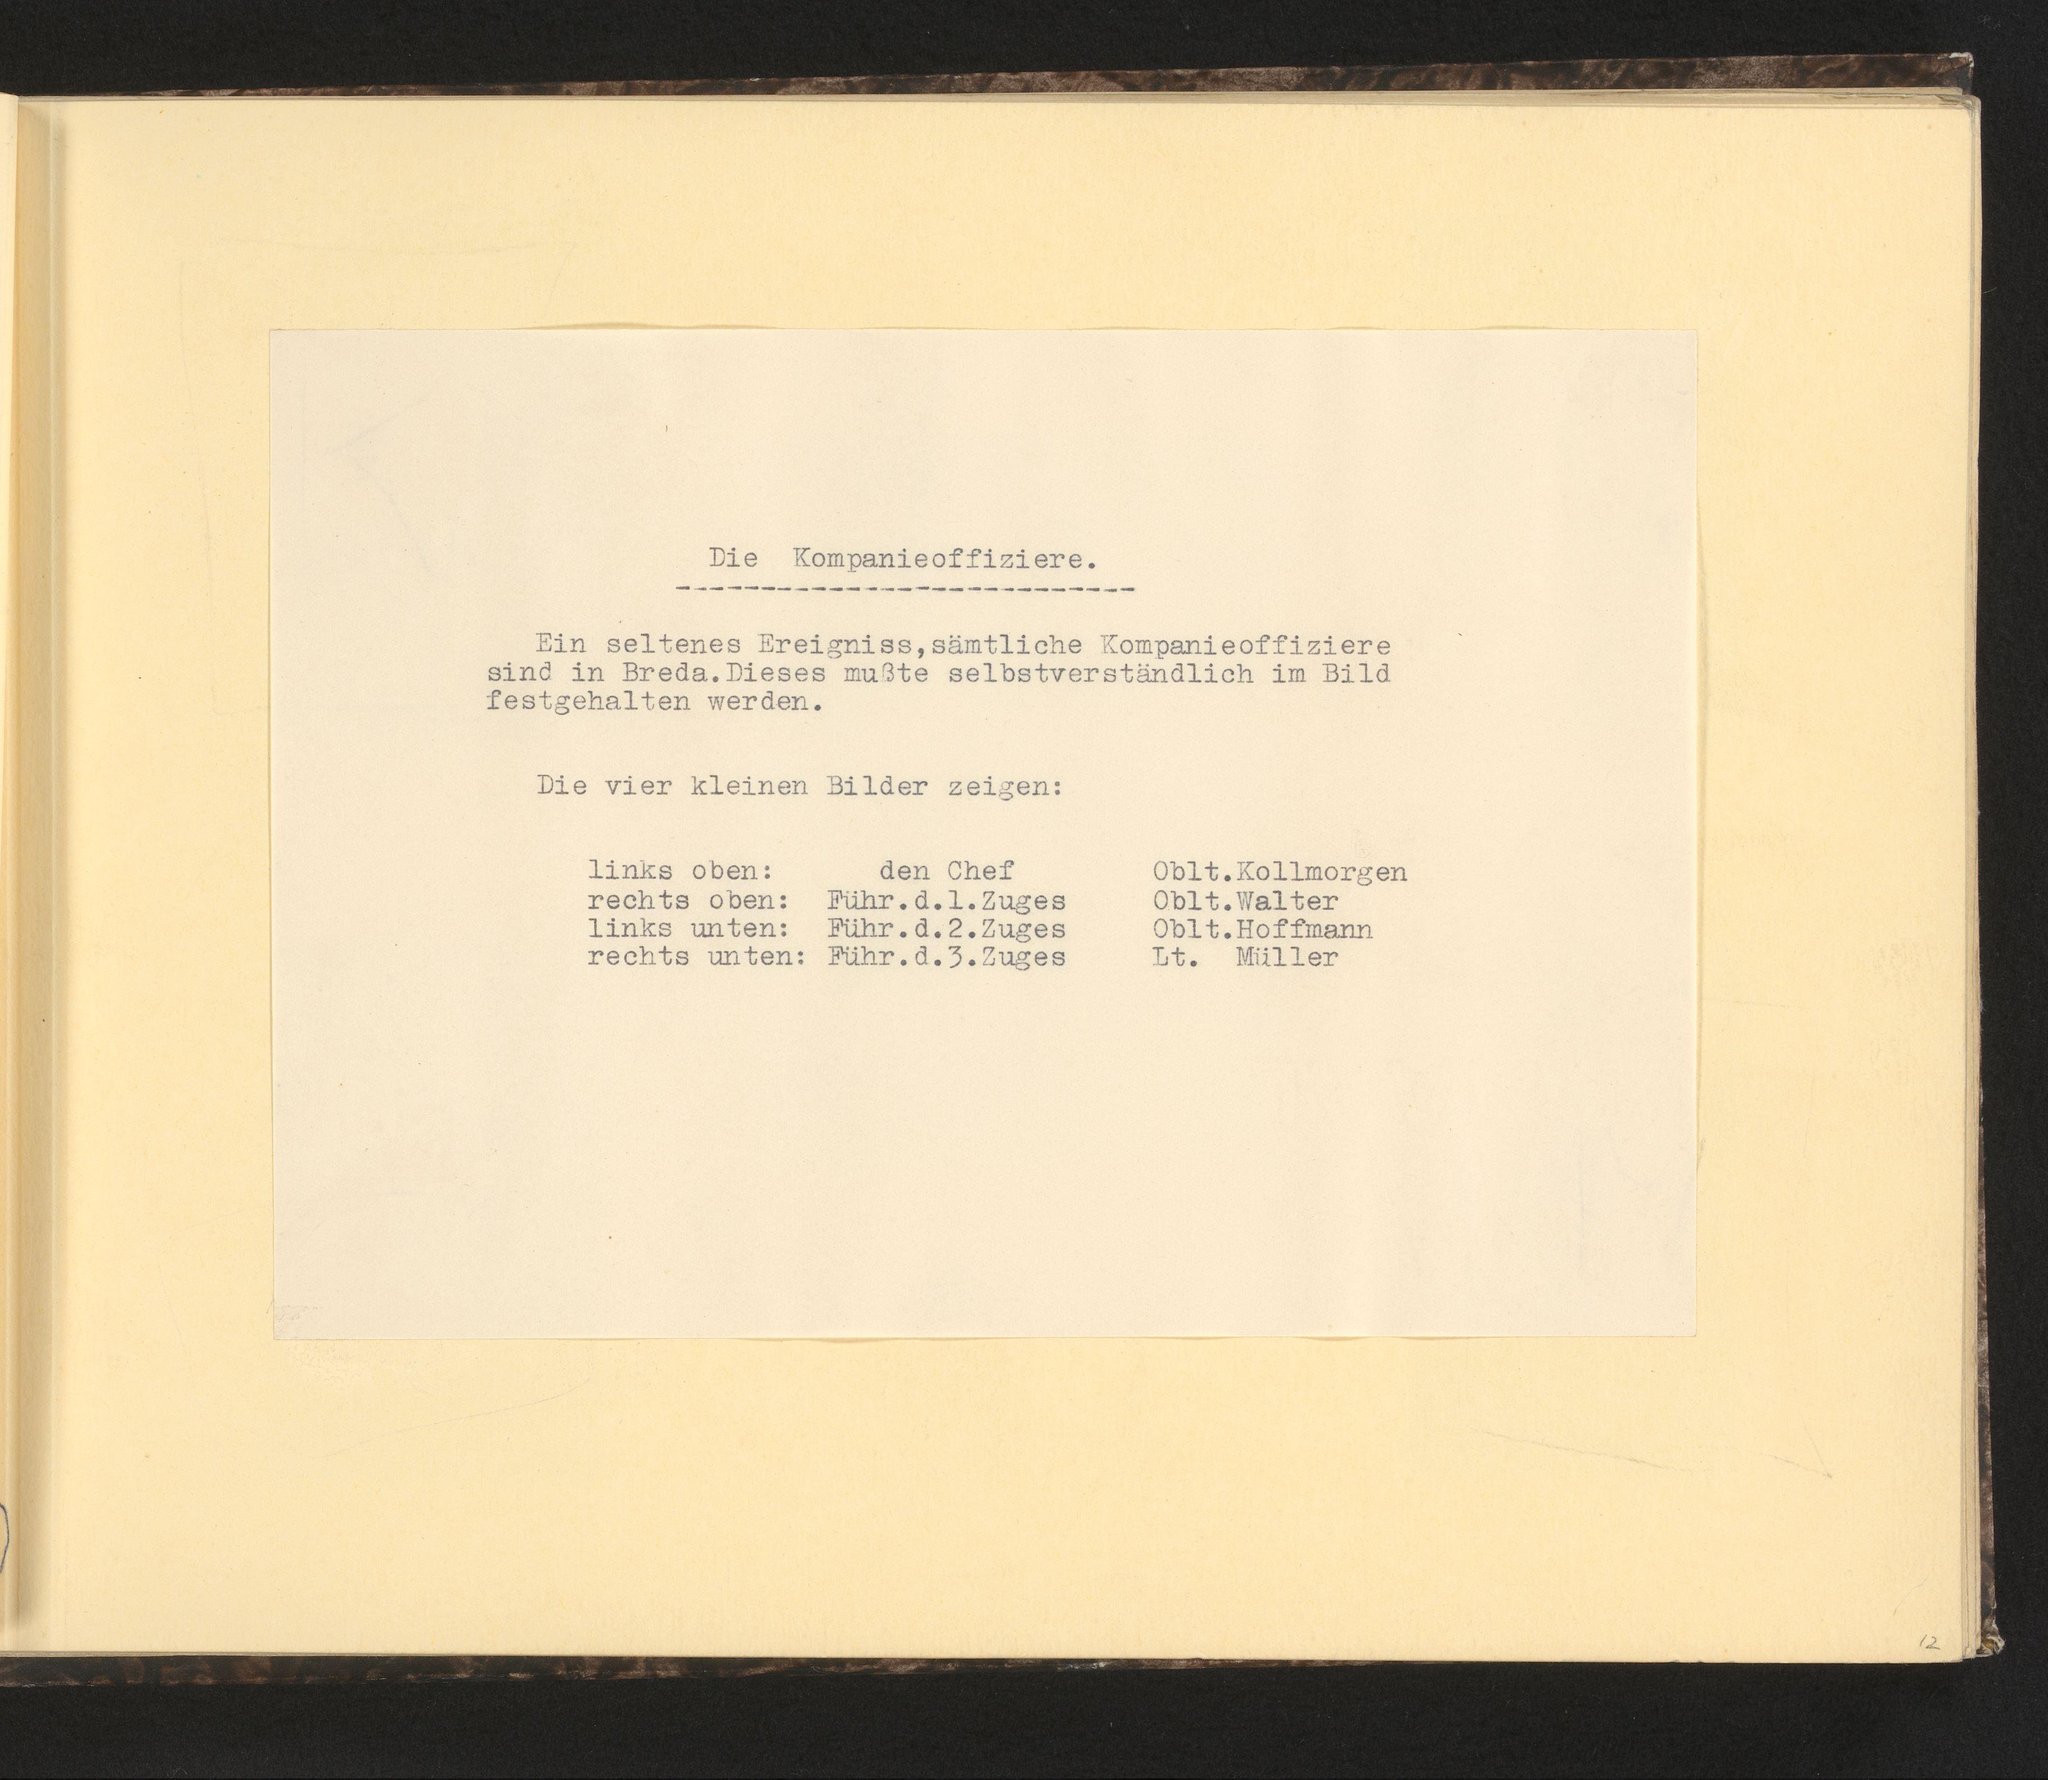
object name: text sheet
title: Tekst over de officieren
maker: Anonymous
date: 1942-1943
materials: cardboard, paper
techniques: printing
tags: officer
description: Albumblad met stencil met informatie over de officieren van de compagnie (op de foto's op het volgende blad). Onderdeel van het fotoalbum van de Luftnachrichten-Regiment 211,1942-1943.